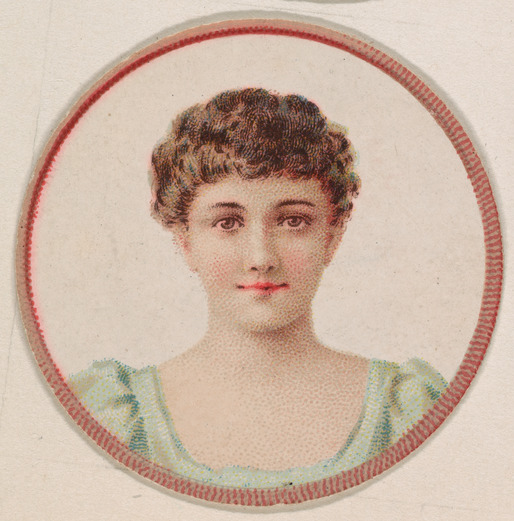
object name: print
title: Portrait of woman, from the Novelties series (N228, Type 2) issued by Kinney Bros.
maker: kinney brothers tobacco company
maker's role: publisher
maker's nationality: american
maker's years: 1869-2011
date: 1889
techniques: color lithograph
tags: portraits,women